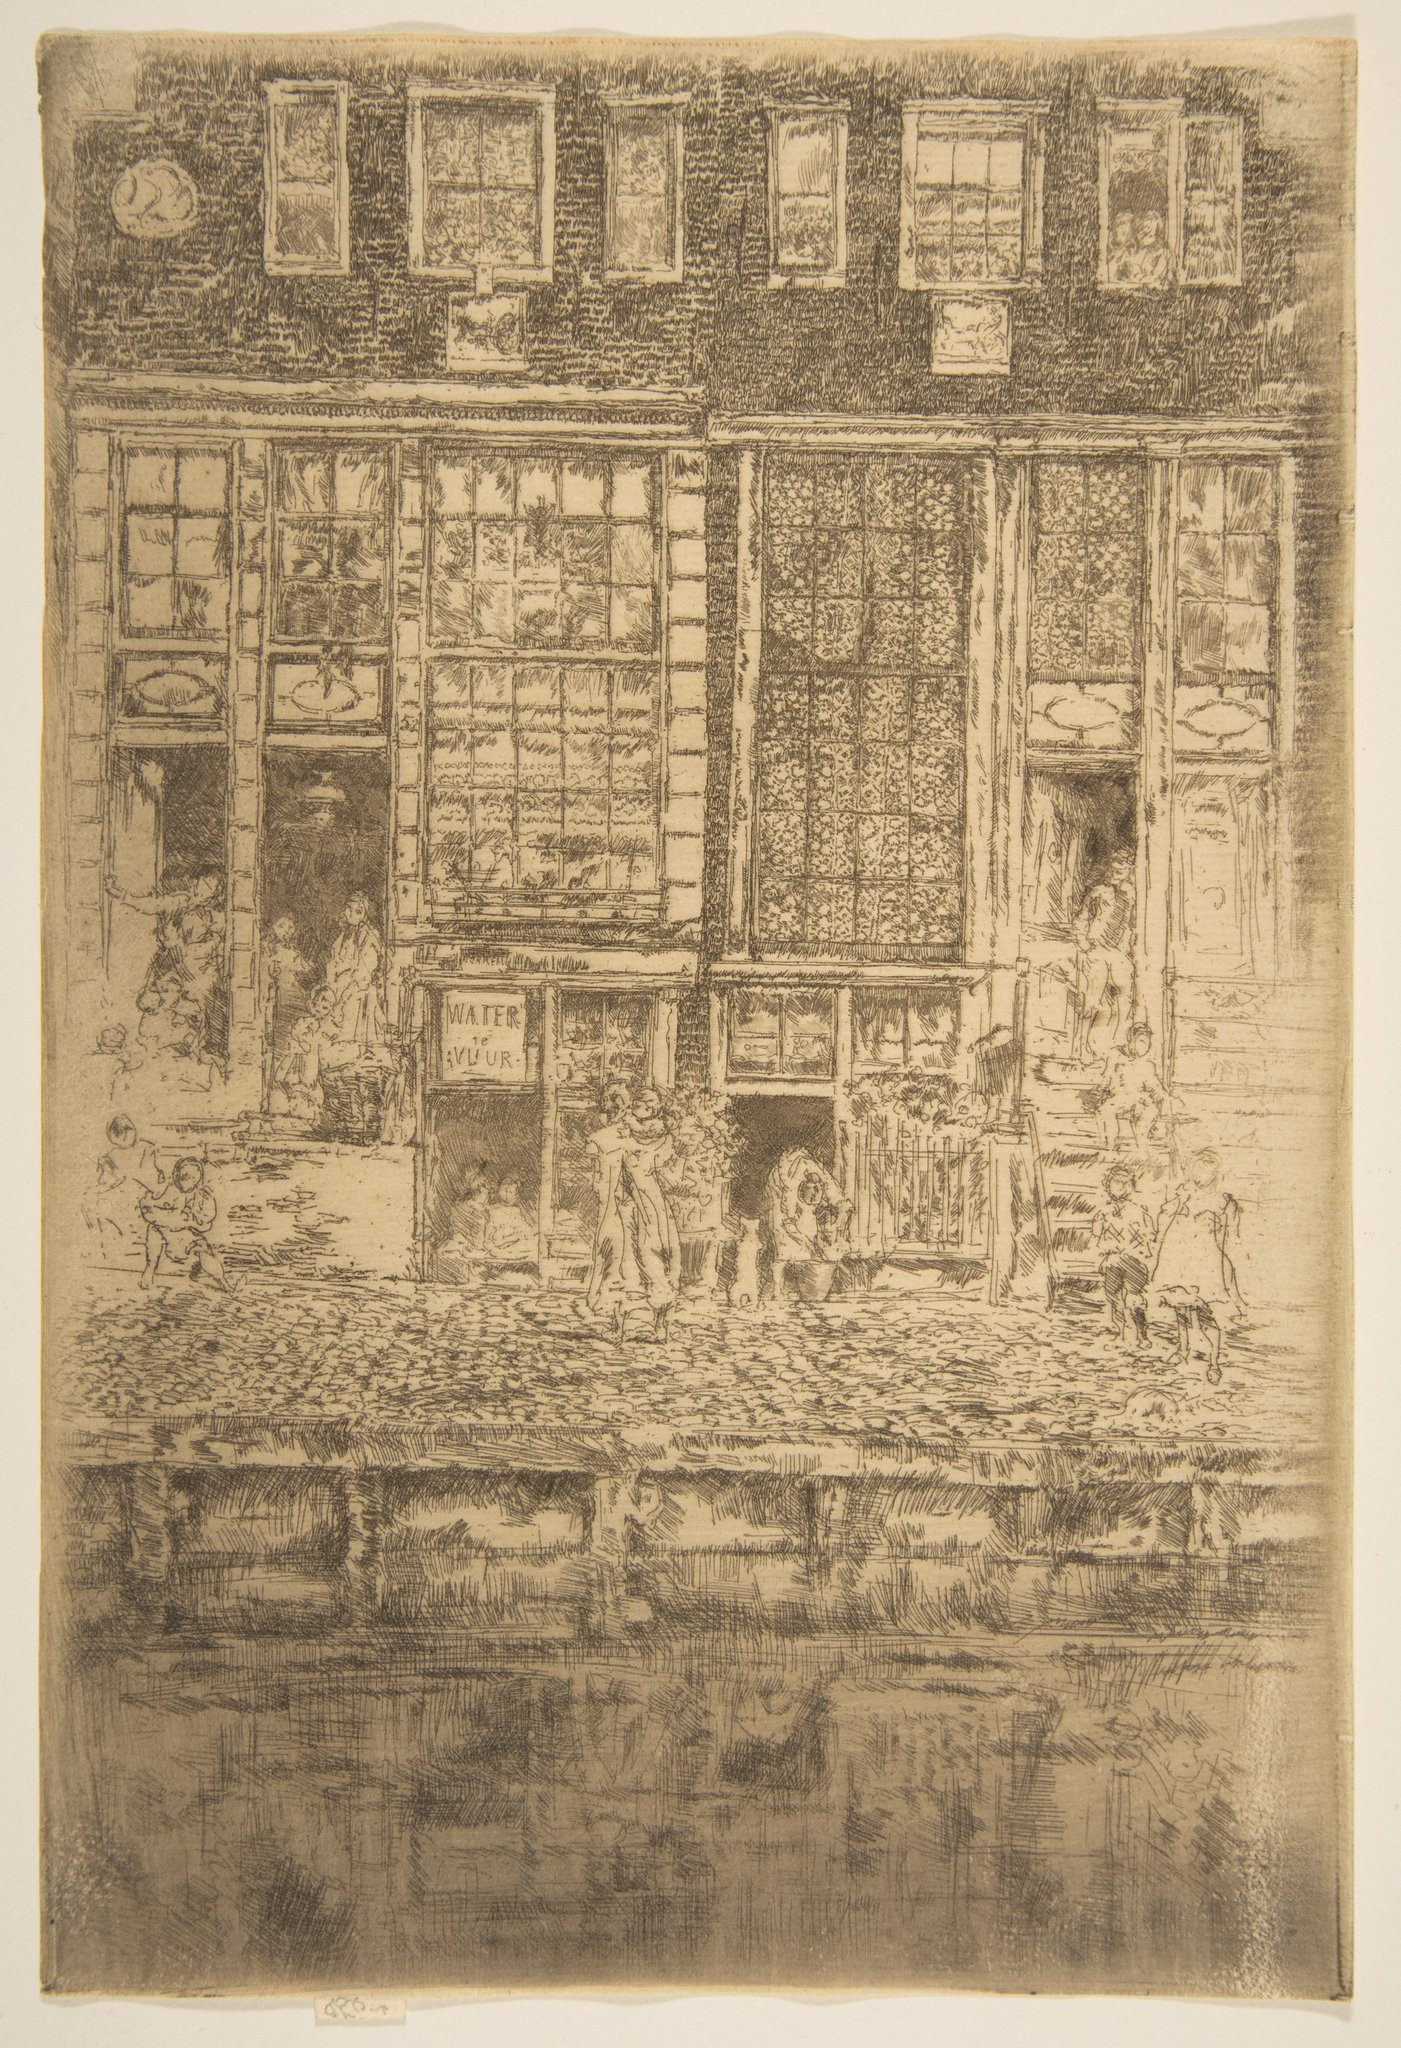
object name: print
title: The Embroidered Curtain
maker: james mcneill whistler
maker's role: artist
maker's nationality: american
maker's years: 1834-1903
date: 1889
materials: ink, paper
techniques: drypoint, etching, printing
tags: cities,amsterdam